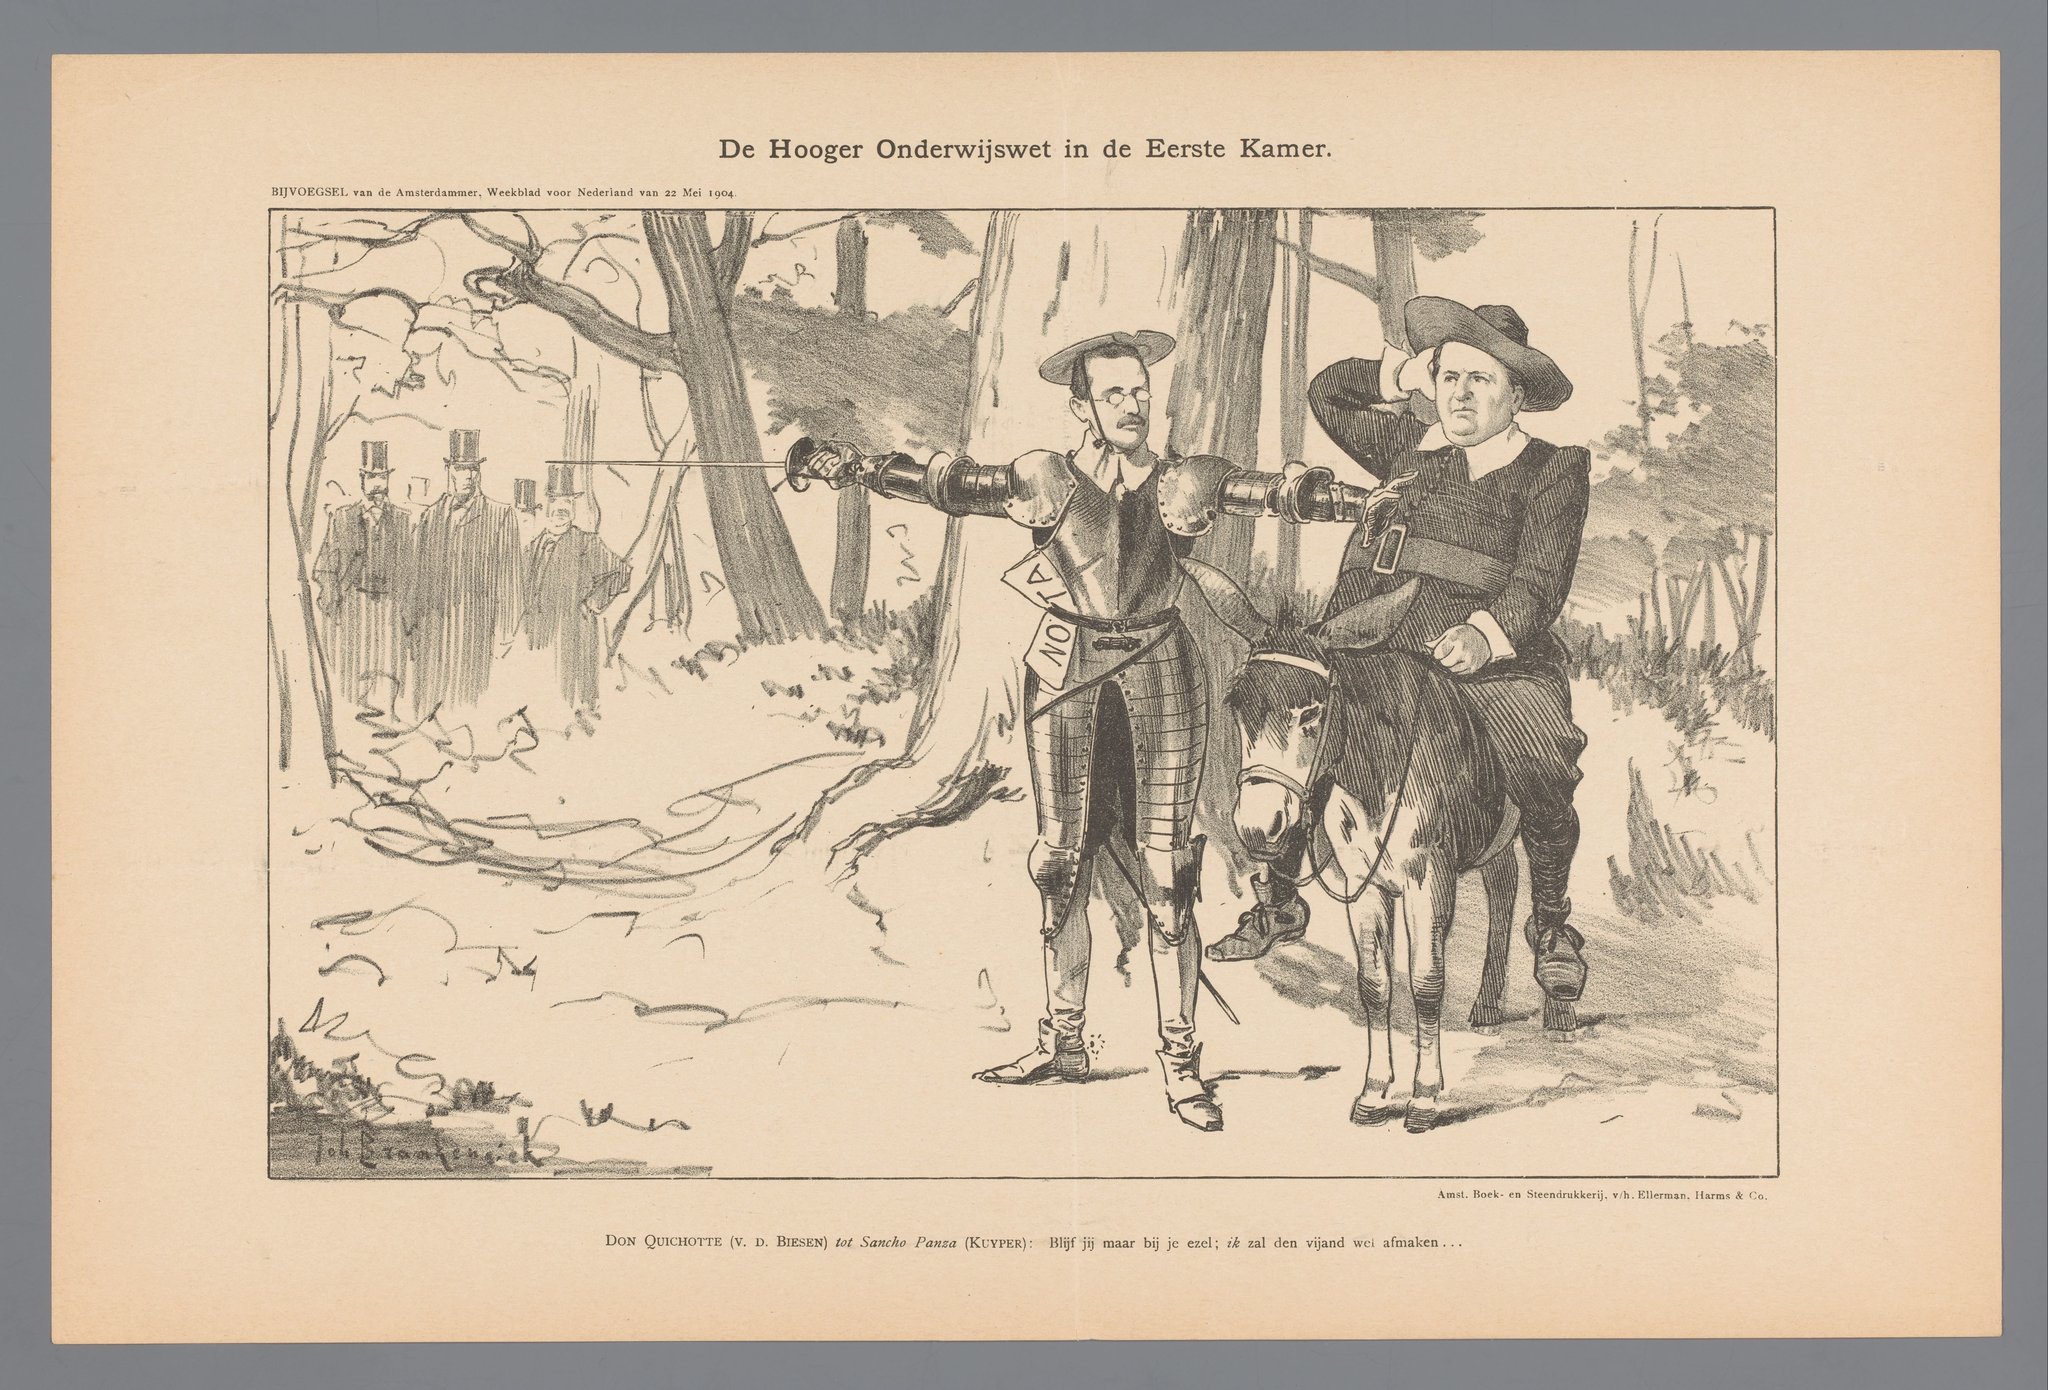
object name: cartoon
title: De Hooger Onderwijswet in de Eerste Kamer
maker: johan braakensiek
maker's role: draughtsman, print maker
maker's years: 1858-1940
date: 1904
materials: paper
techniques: lithograph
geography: amsterdam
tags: the hague, abraham kuyper, (scenes from) specific works of literature (with author, title), historical persons, education, political caricatures and satires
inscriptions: date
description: Prent uit het bijvoegsel van: De Amsterdammer. Weekblad voor Nederland, 22 mei 1904.